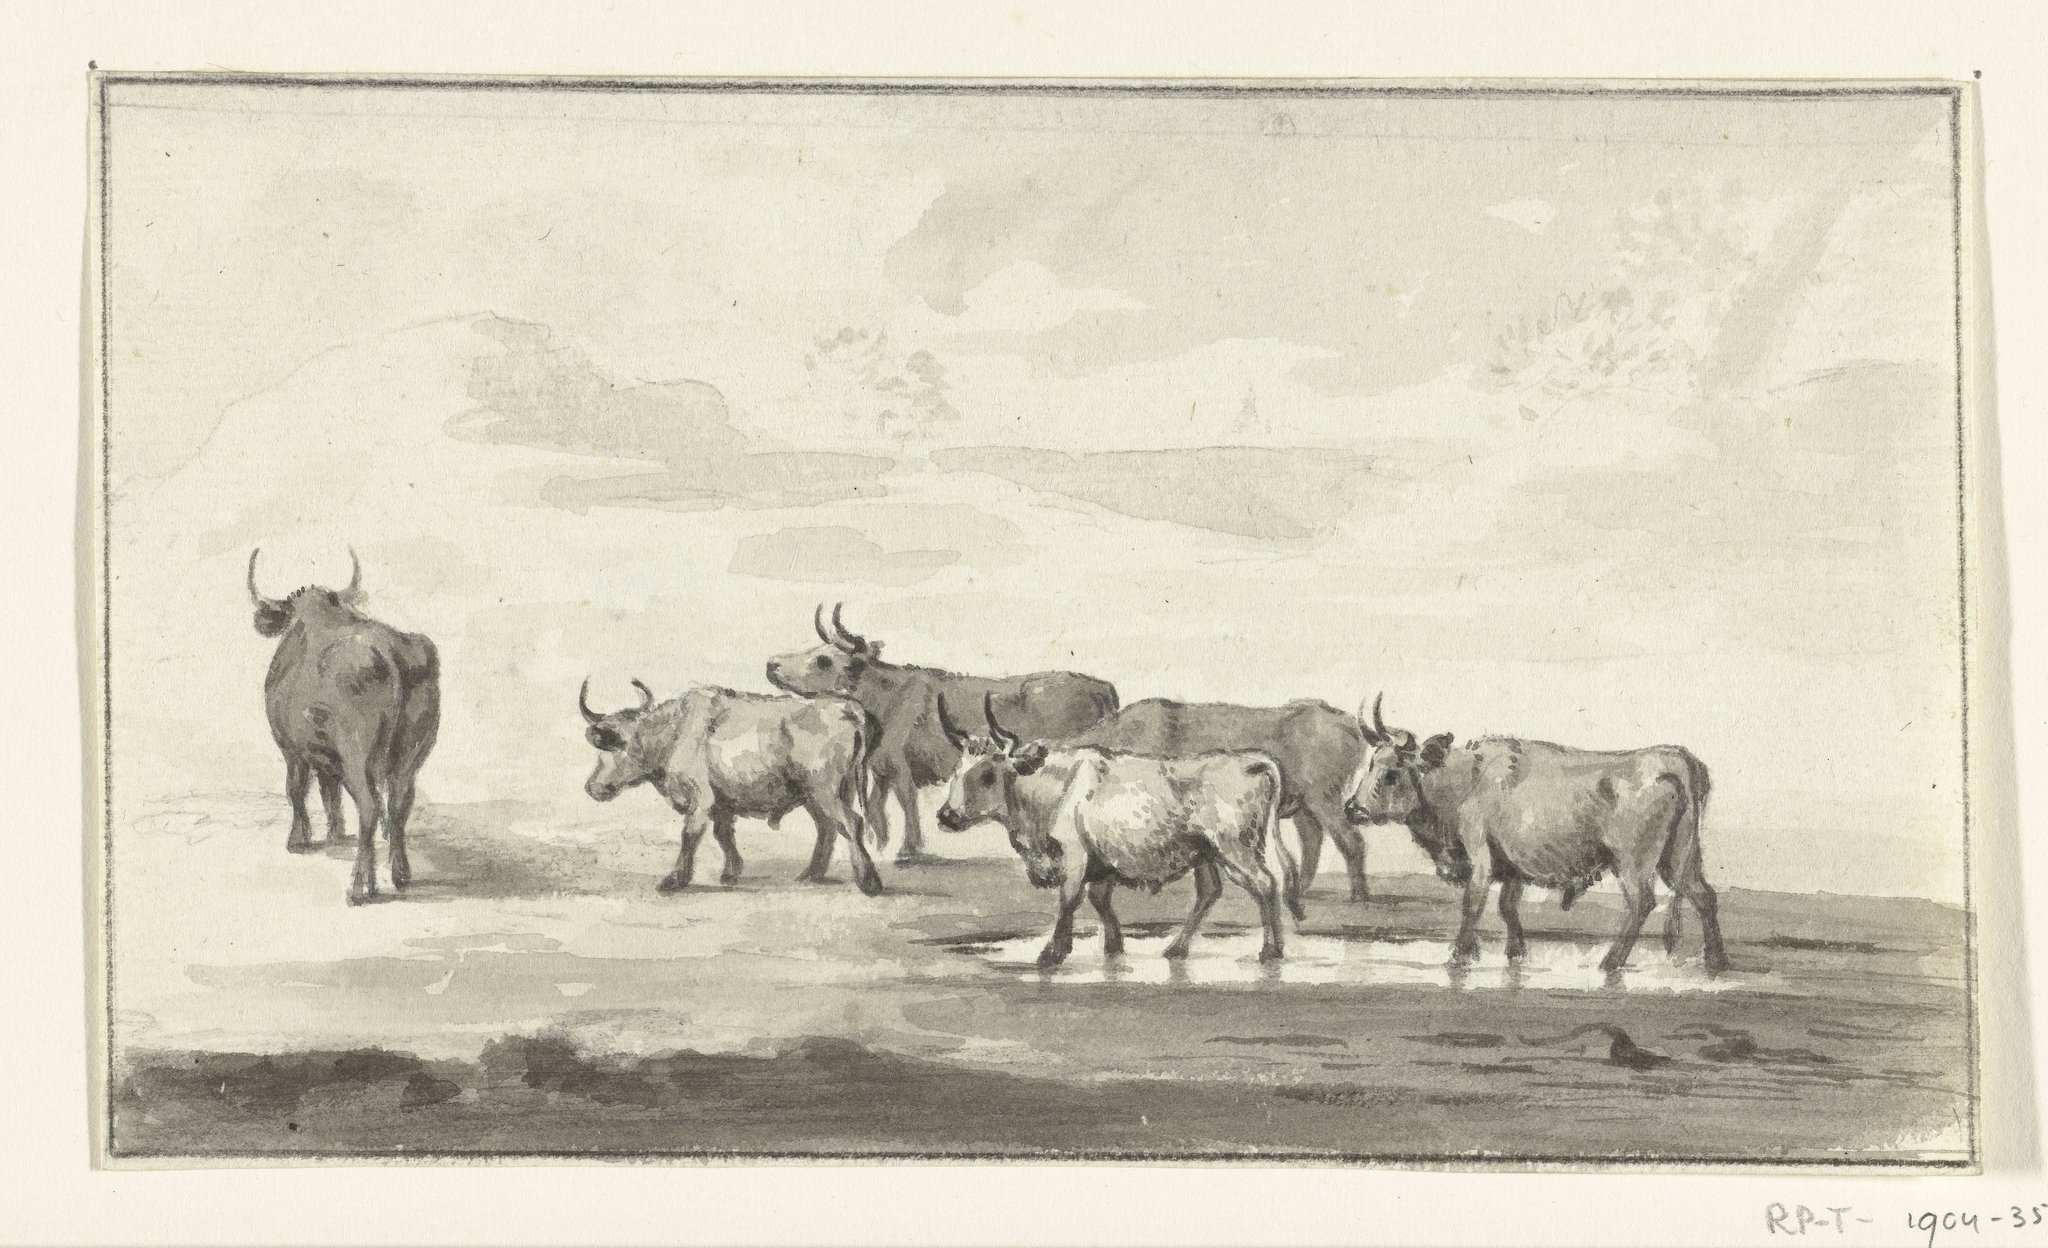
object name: drawing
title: Groep van zes stieren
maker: jean bernard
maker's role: draughtsman, print maker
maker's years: 1765-1833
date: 1775-1833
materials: ink, paper, pencil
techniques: brush, pen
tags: bull